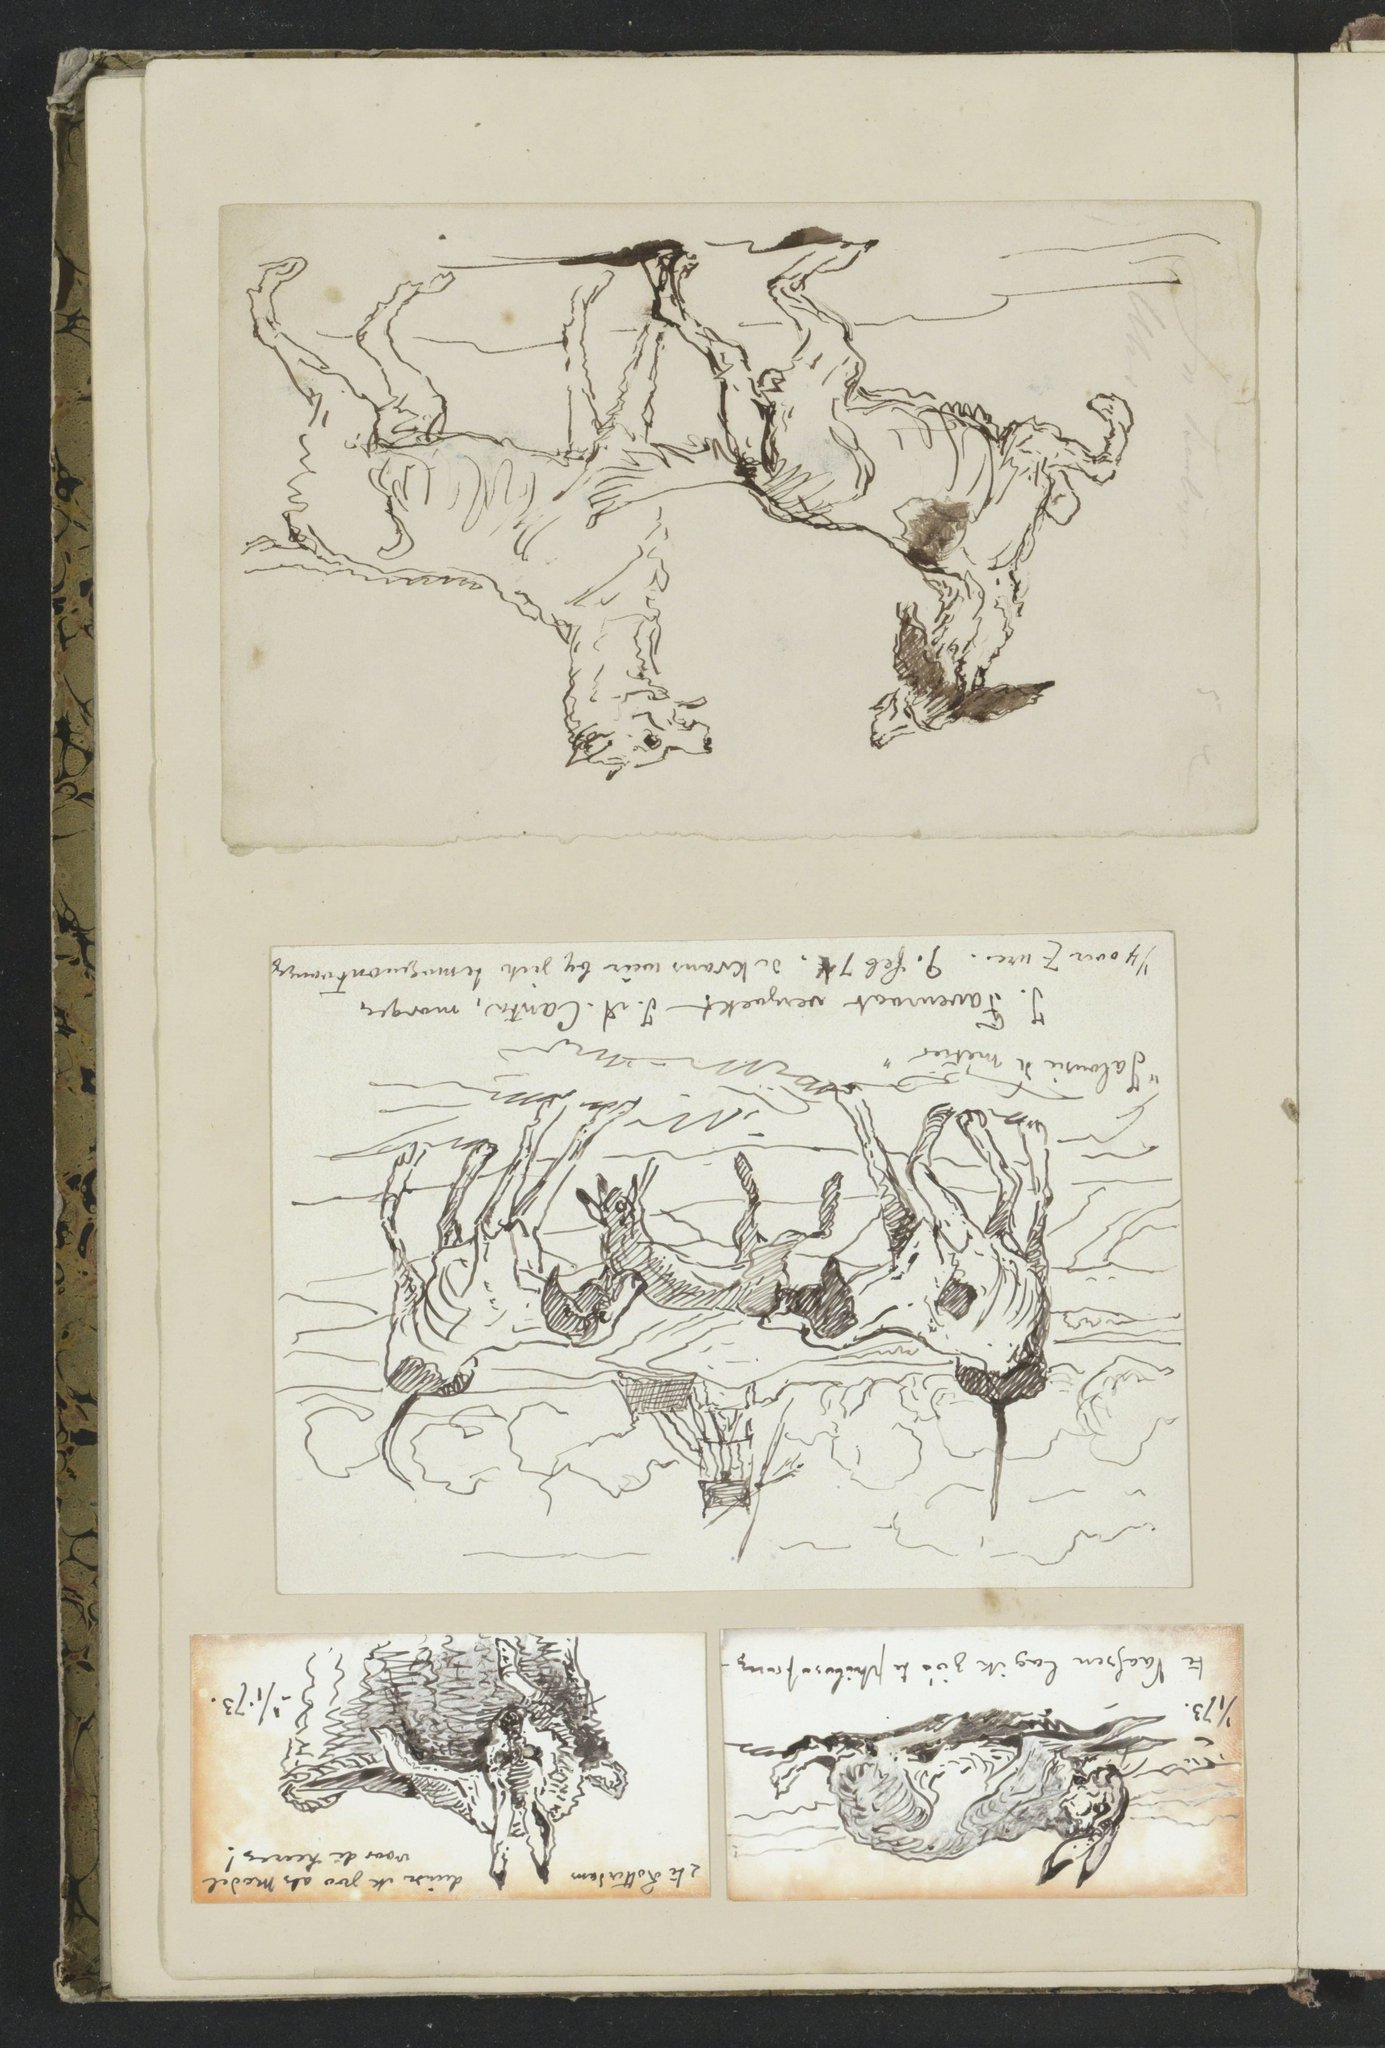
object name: sketchbook leaf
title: Hazen, landschap met een molen en twee honden die een haas uiteen rijten en twee honden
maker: johannes antonius canta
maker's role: draughtsman, painter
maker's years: 1816-1888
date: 1873-1874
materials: ink, paper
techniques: brush, pen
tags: rodents: hare, windmill in landscape, dog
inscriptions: date and inscription: ‘& te Rotterdam/ diende ik zoo als model/ 1/1 73’, date and inscription: ‘"Jalousie de metier"/ J. Tavenraat verzoekt J.A. Canta, morgen/ 1/4 over 7 uren./ 9.feb 74. de krans weer bij zich te mogen ontvangen’, date and inscription: ‘1/1 73/ te Vaalsen lag ik zoó te philoso[...]’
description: Vermoedelijk stuurde Tavenraat deze studies naar Canta. Blad 58 verso uit een schetsboek en album met 59 bladen.